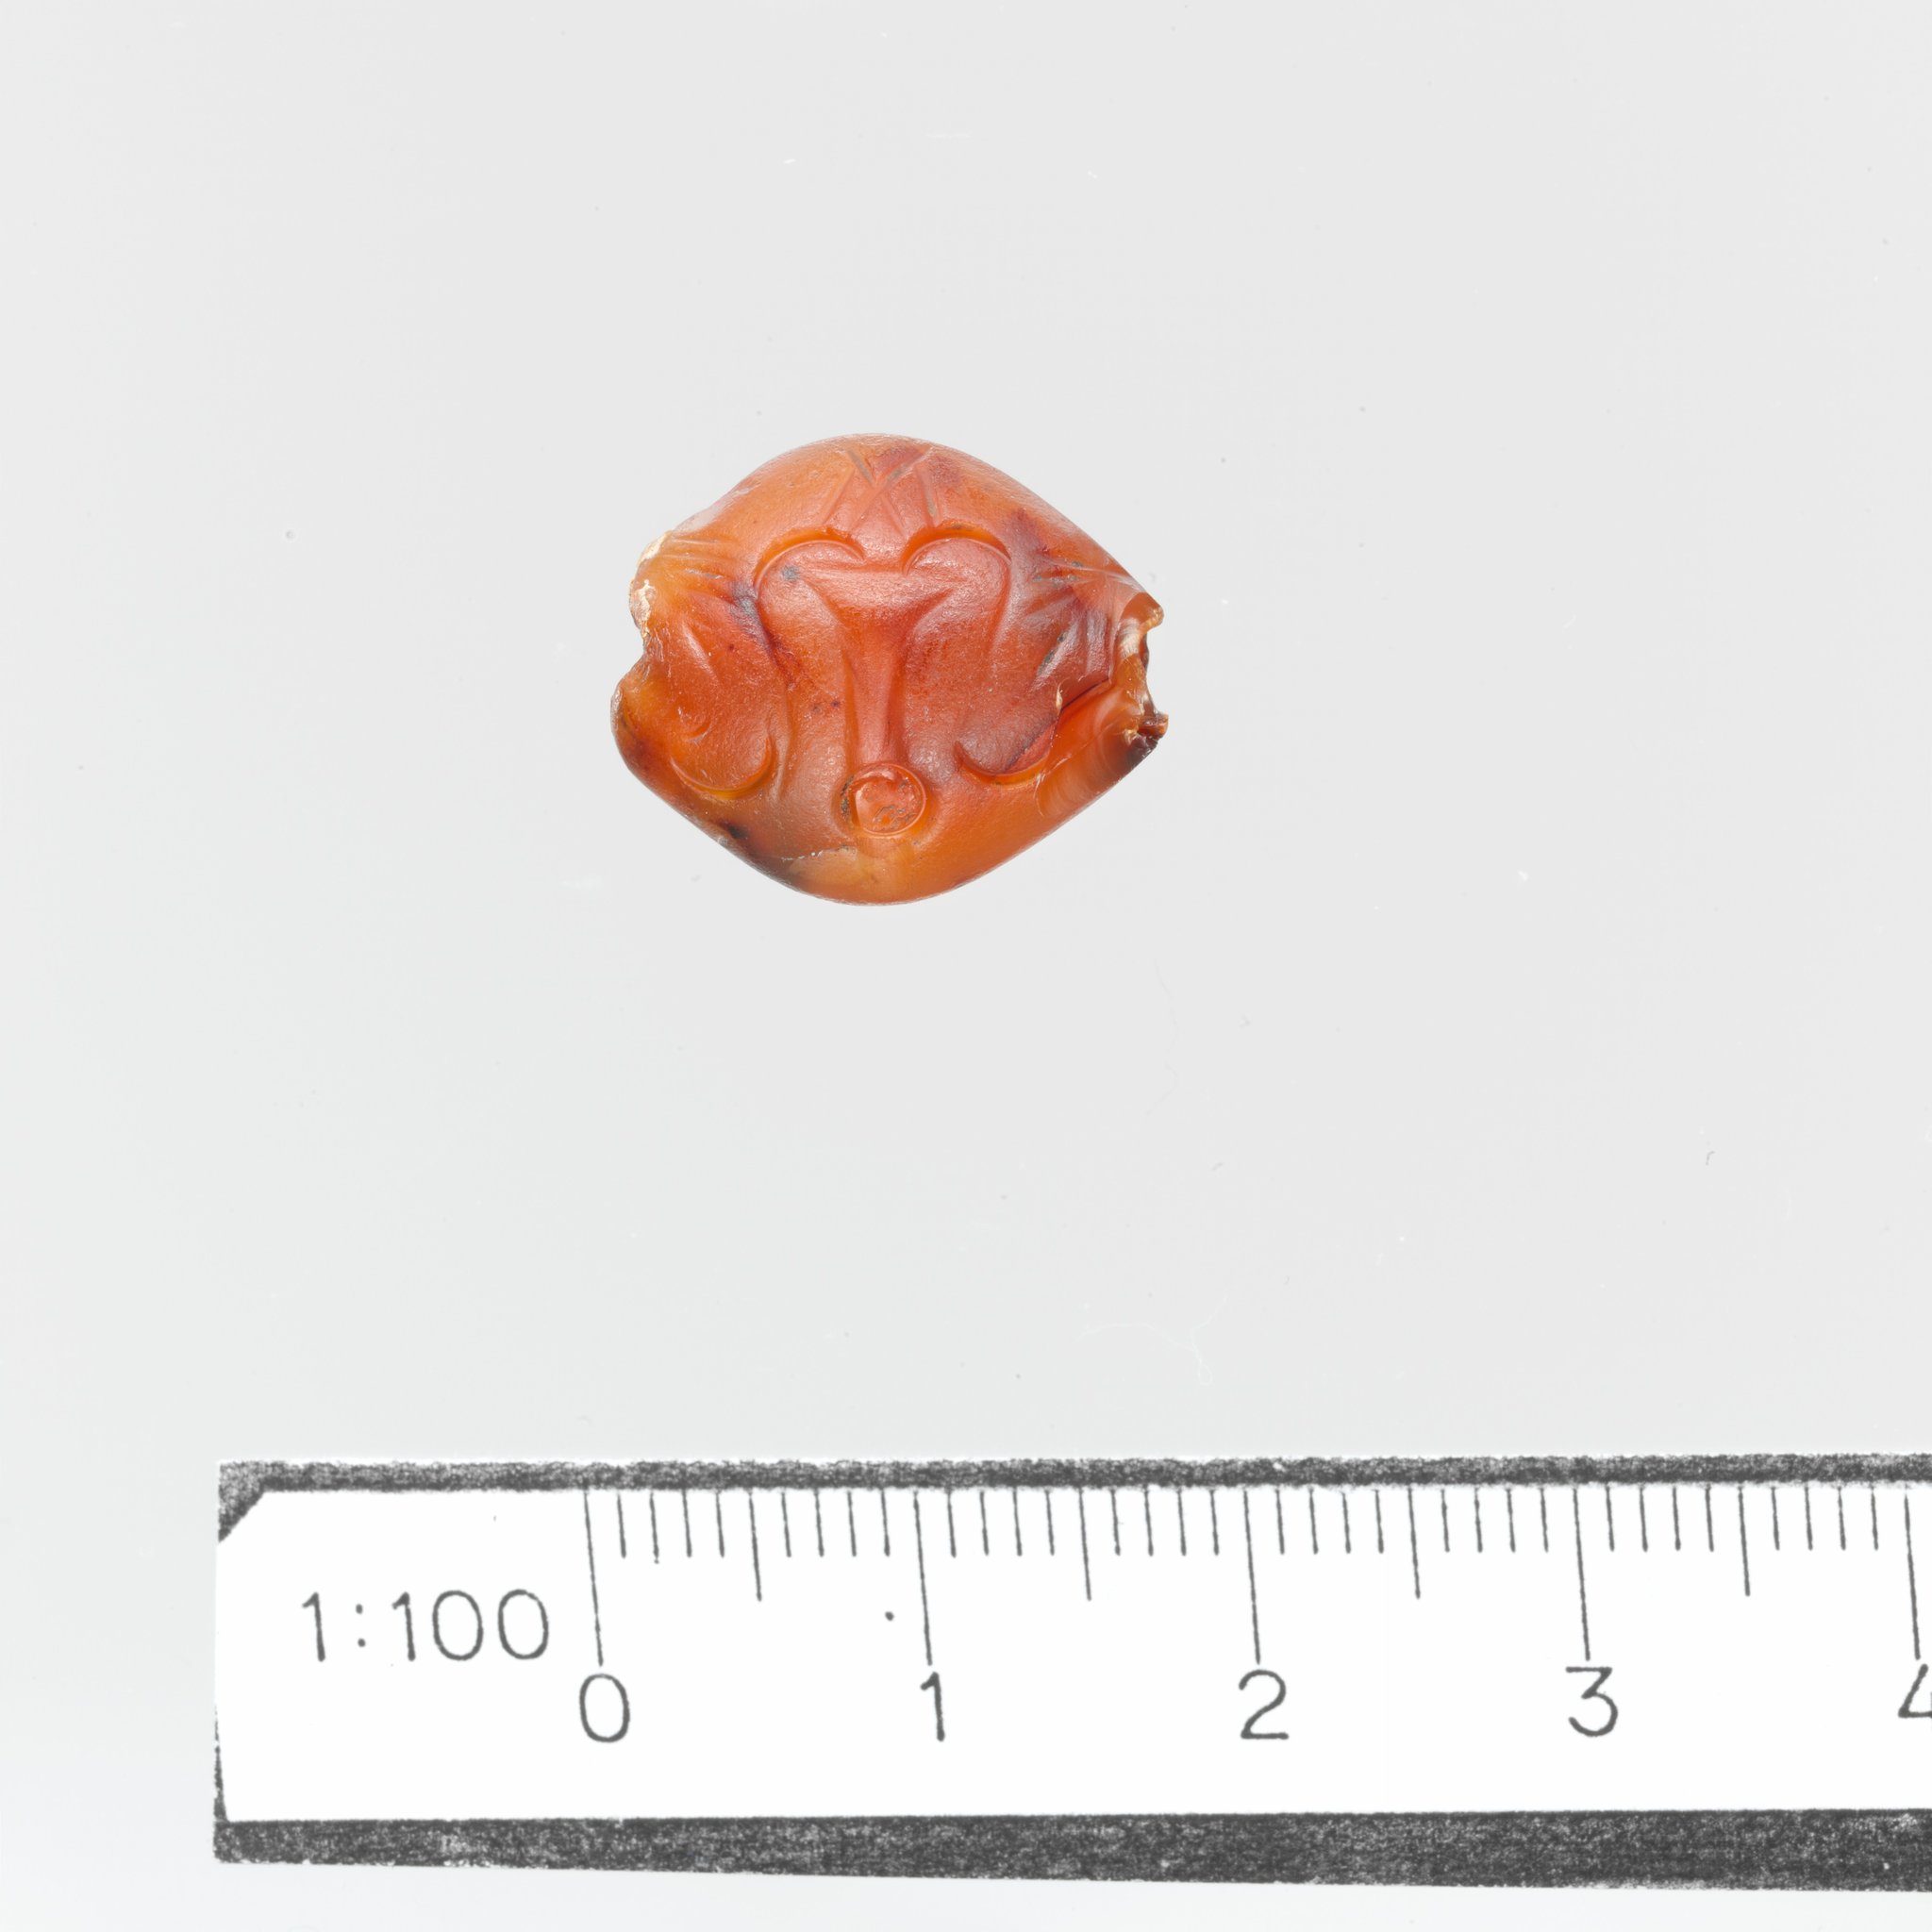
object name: seal, amygdaloid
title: Carnelian amygdaloid seal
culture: minoan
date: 1750-1600 BCE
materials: gemstone